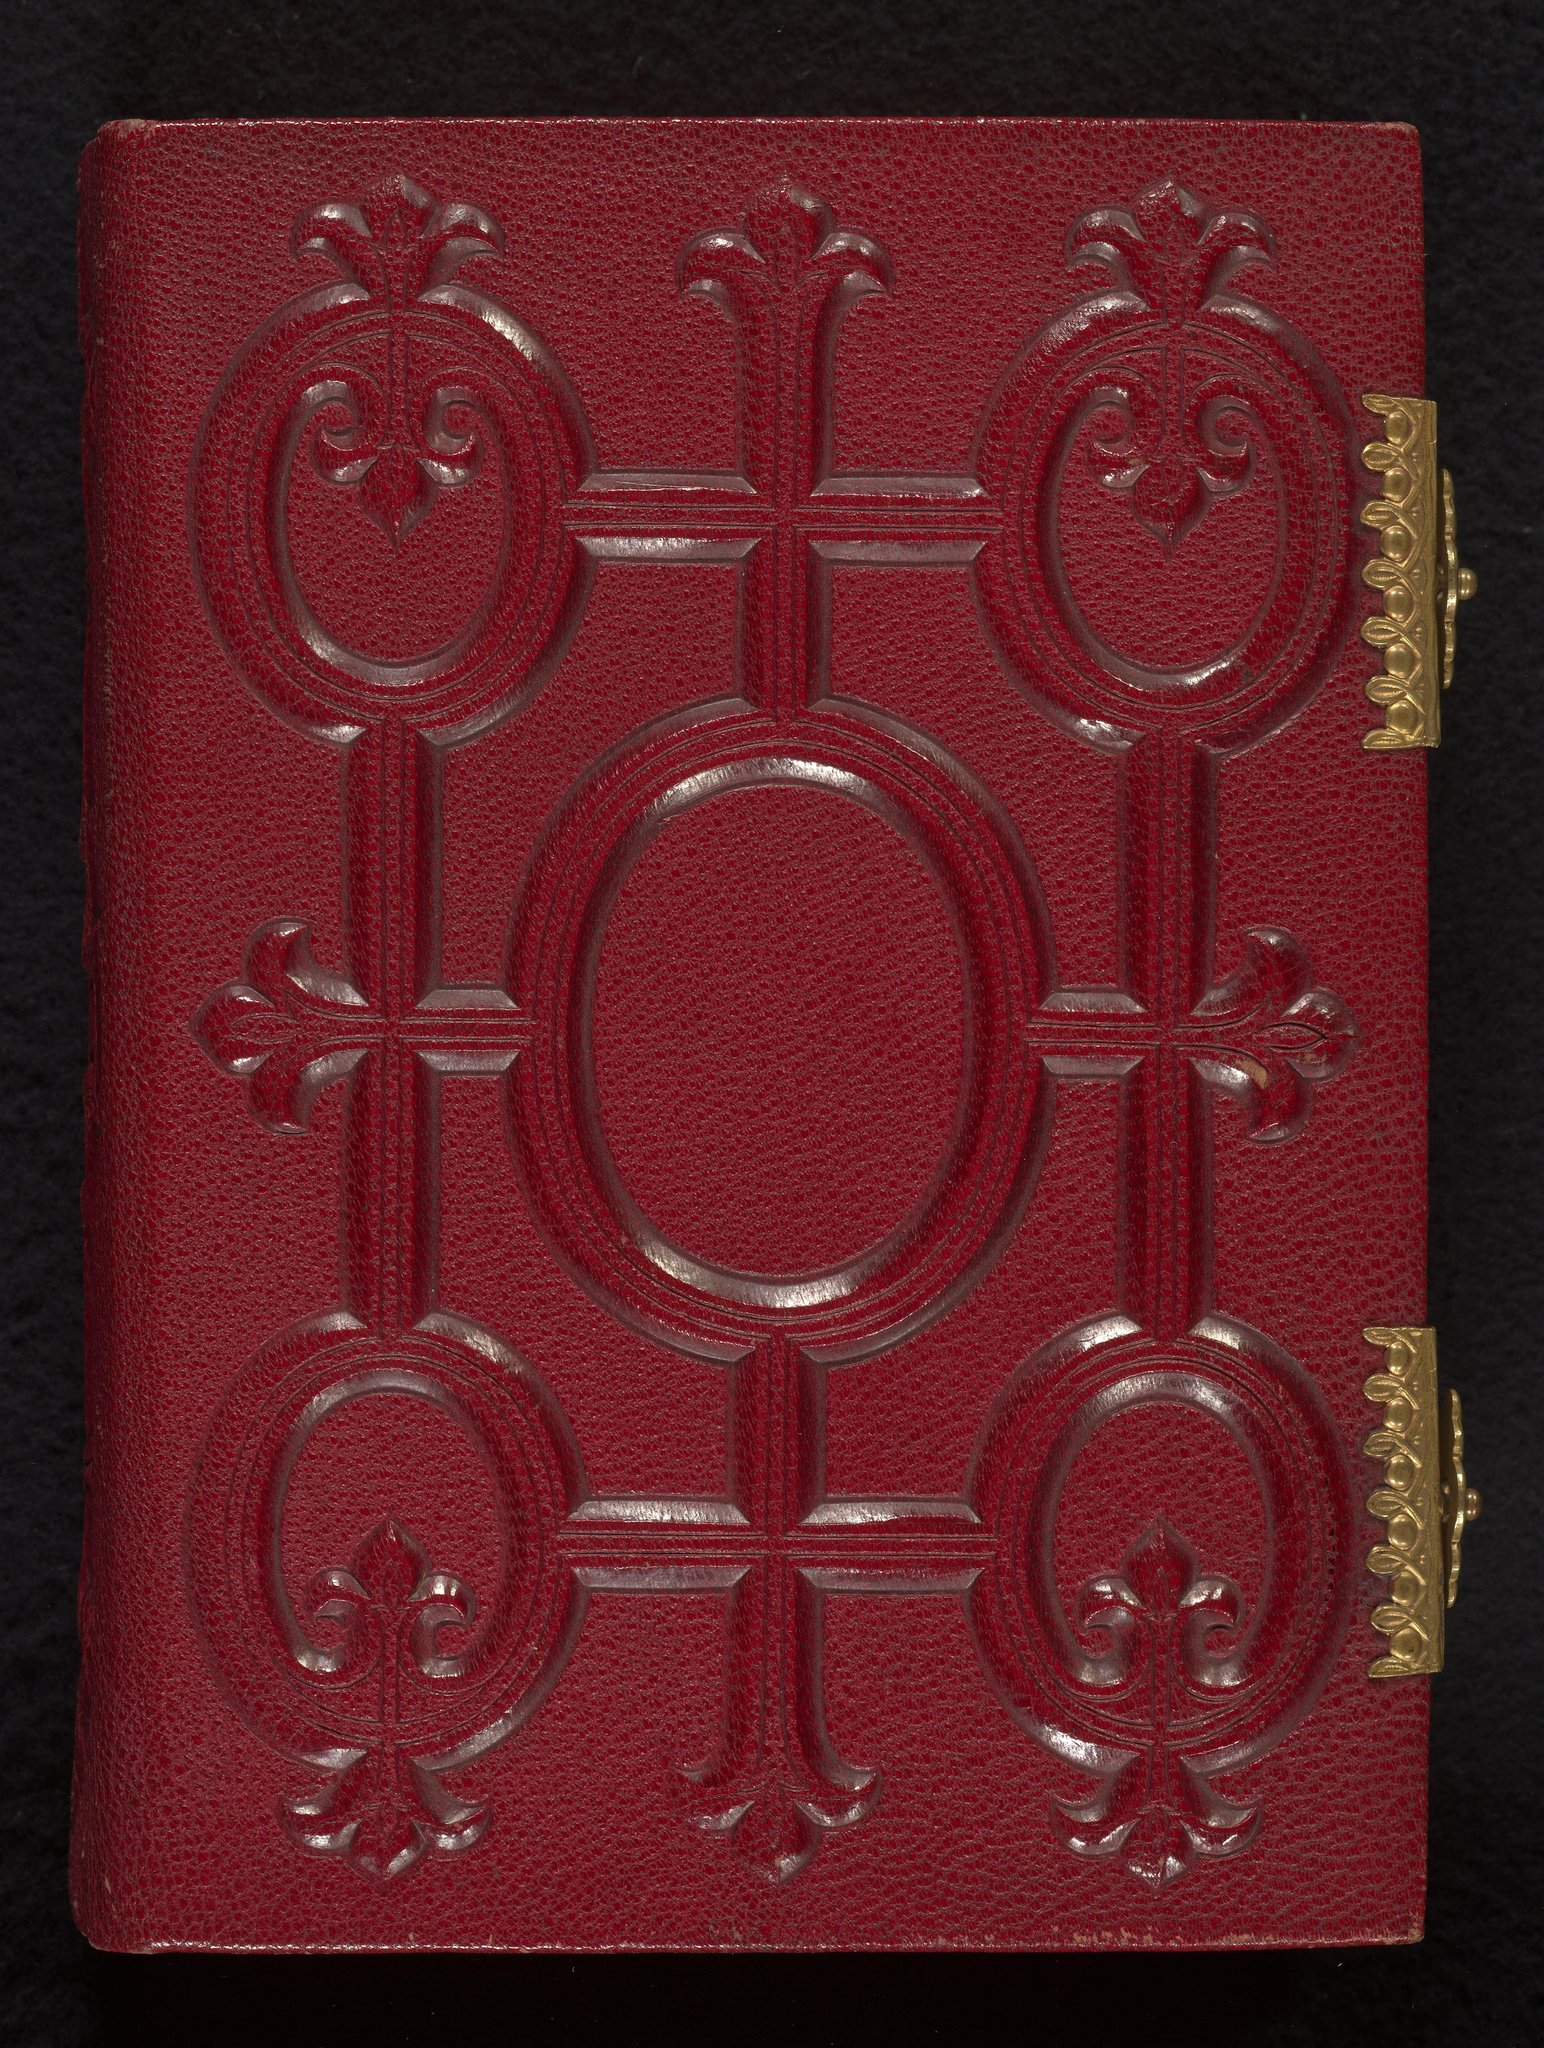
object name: photograph album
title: Nederlands familiealbum met dertig foto's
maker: Anonymous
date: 1860-1900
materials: cardboard, leather, metal, paper, photographic support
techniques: albumen print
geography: netherlands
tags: historical persons - bb - woman, child, historical persons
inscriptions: collector's mark: ‘DIENST/ VERSPREIDE/ RIJKSKOLLEKTIES/ (...) A 766’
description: Fotoalbum met dertig pagina's met dertig cartes-de-visite in met gepreegde rand omkaderde passe-partouts. Afgebeeld zijn portretten van onbekende mannen, vrouwen en kinderen, vermoedelijk uit één familie. Sommige geportretteerden komen meerdere keren voor in het album. De foto's zijn gemaakt door verschillende Nederlandse fotografen, waaronder H.J. Weesing en Cornelis Johannes Lodewicus Vermeulen. Van acht foto's is de fotograaf anoniem.